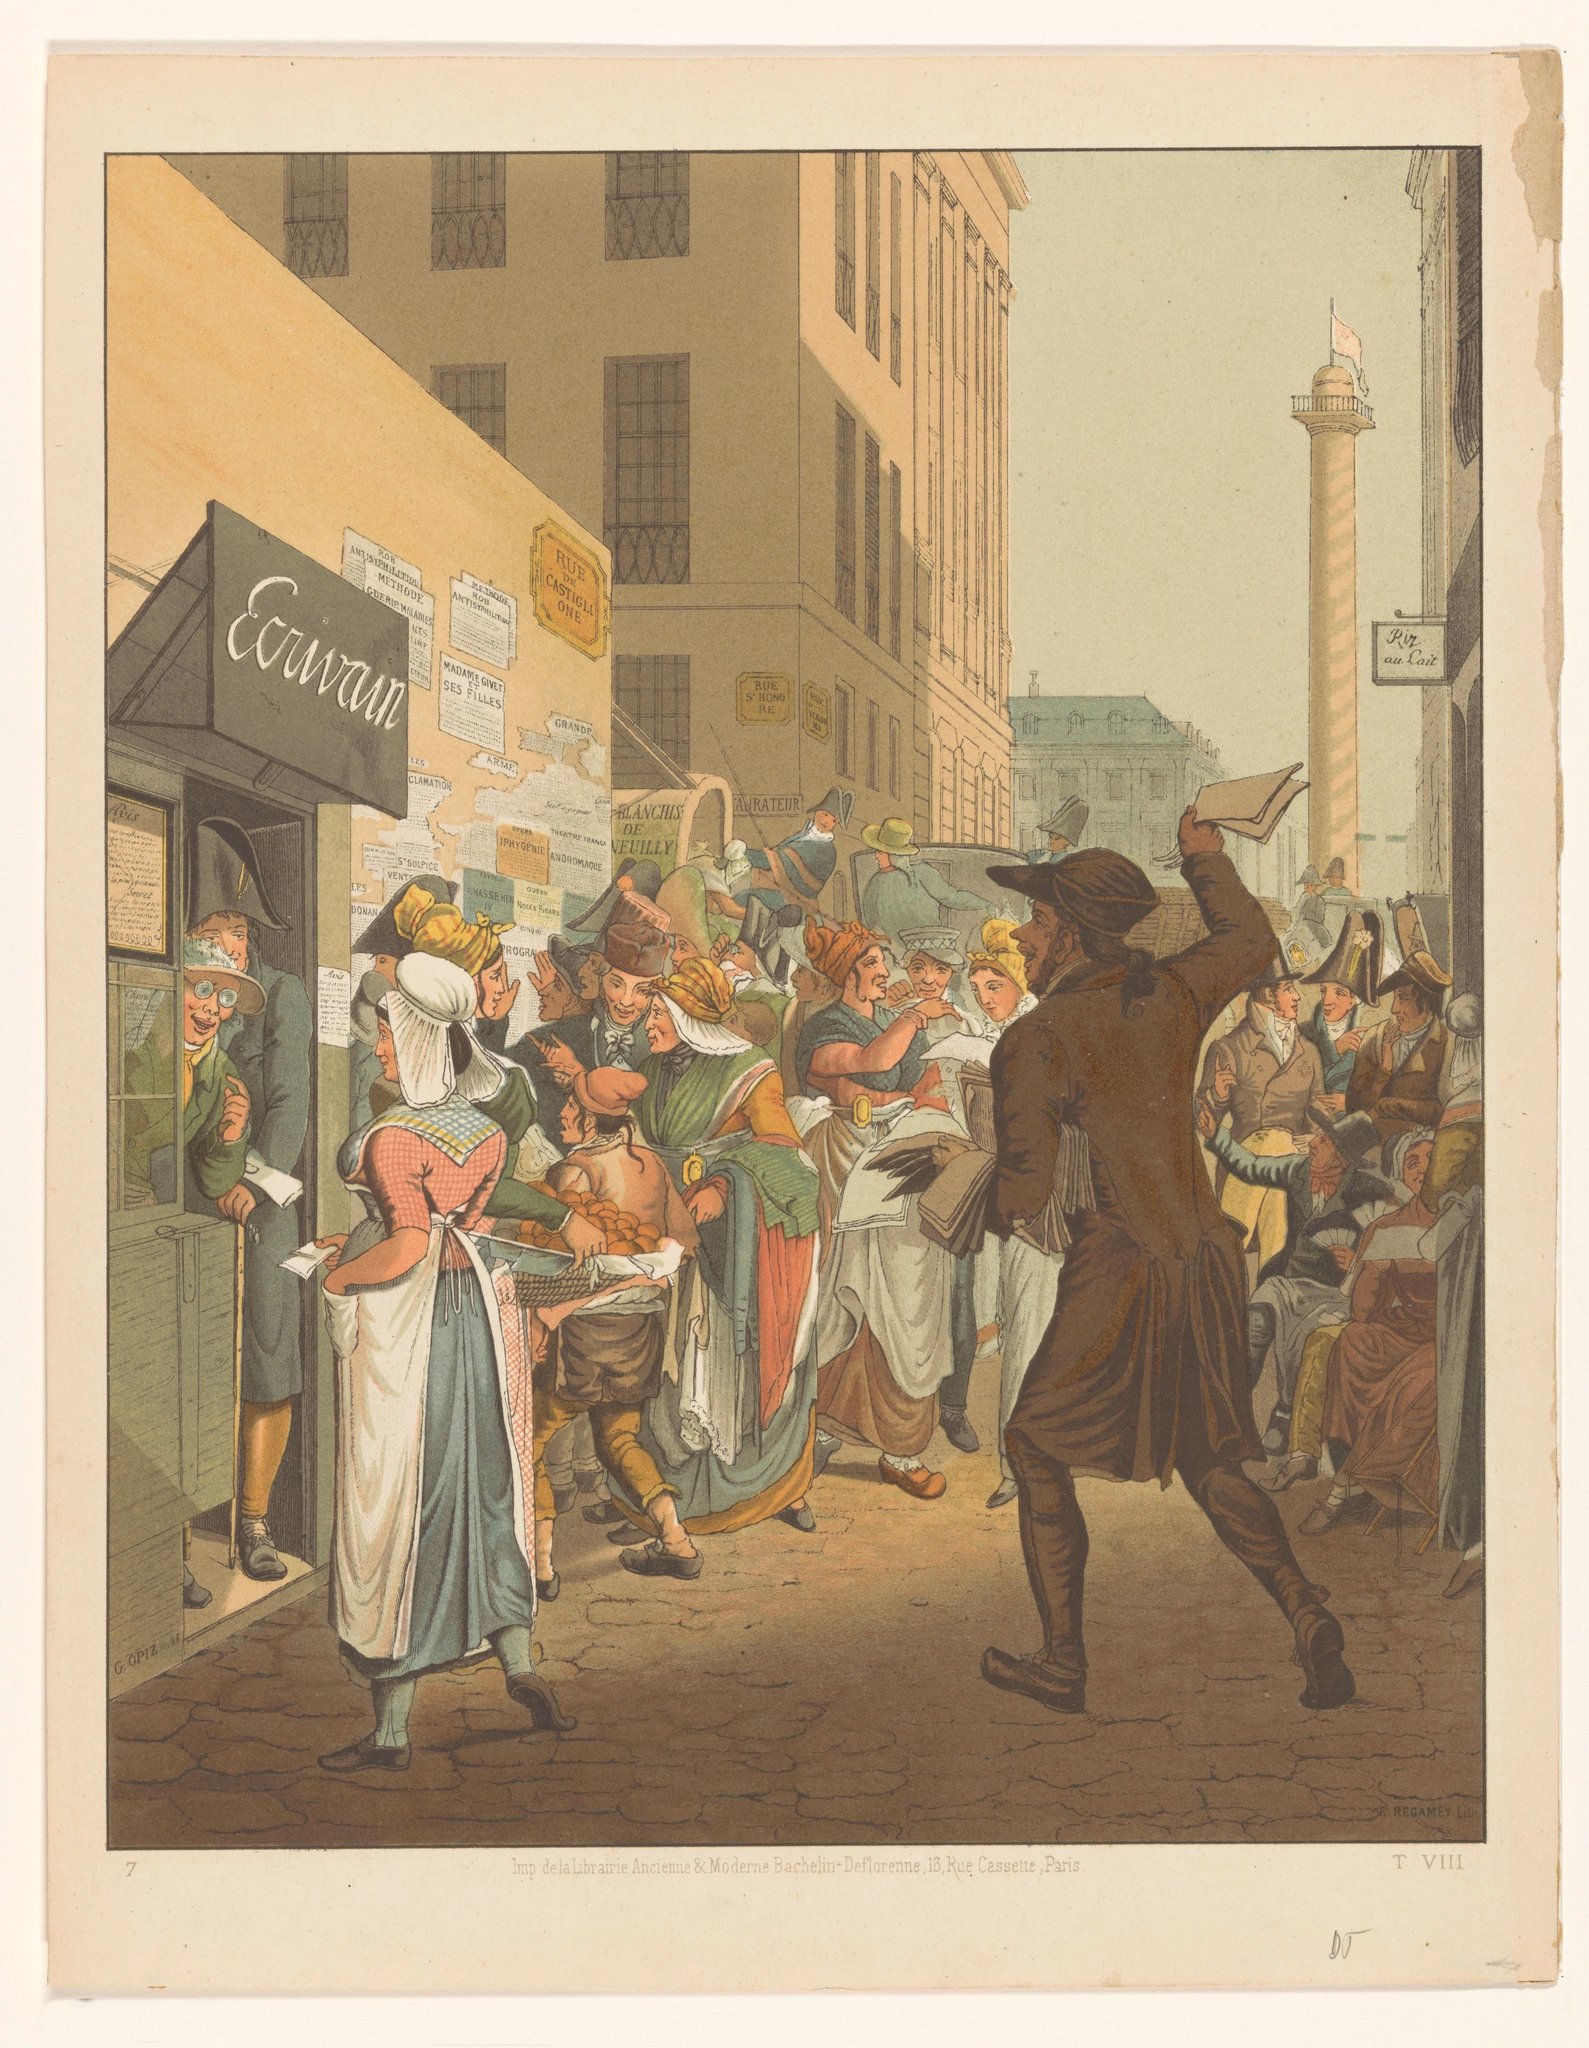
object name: book illustration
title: Gezicht op de Rue de Castiglione te Parijs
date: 1850-1900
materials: paper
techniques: lithograph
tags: delivery (of newspaper), street-trader, city-view in general; 'veduta' (+ city(-scape) with figures, staffage), shop-window, show-window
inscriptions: collector's mark: Lugt 4780, collector's mark: Lugt 2228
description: Straatscène met tal van figuren, waaronder een krantverkoper en een vrouw met een mand met sinaasappels. Op de voorgrond het loket van een schrijver met op de muur tal van aanplakbiljetten, in de achtergrond de Colonne Vendôme. Rechtsonder genummerd: T VIII en linksonder genummerd: 7.